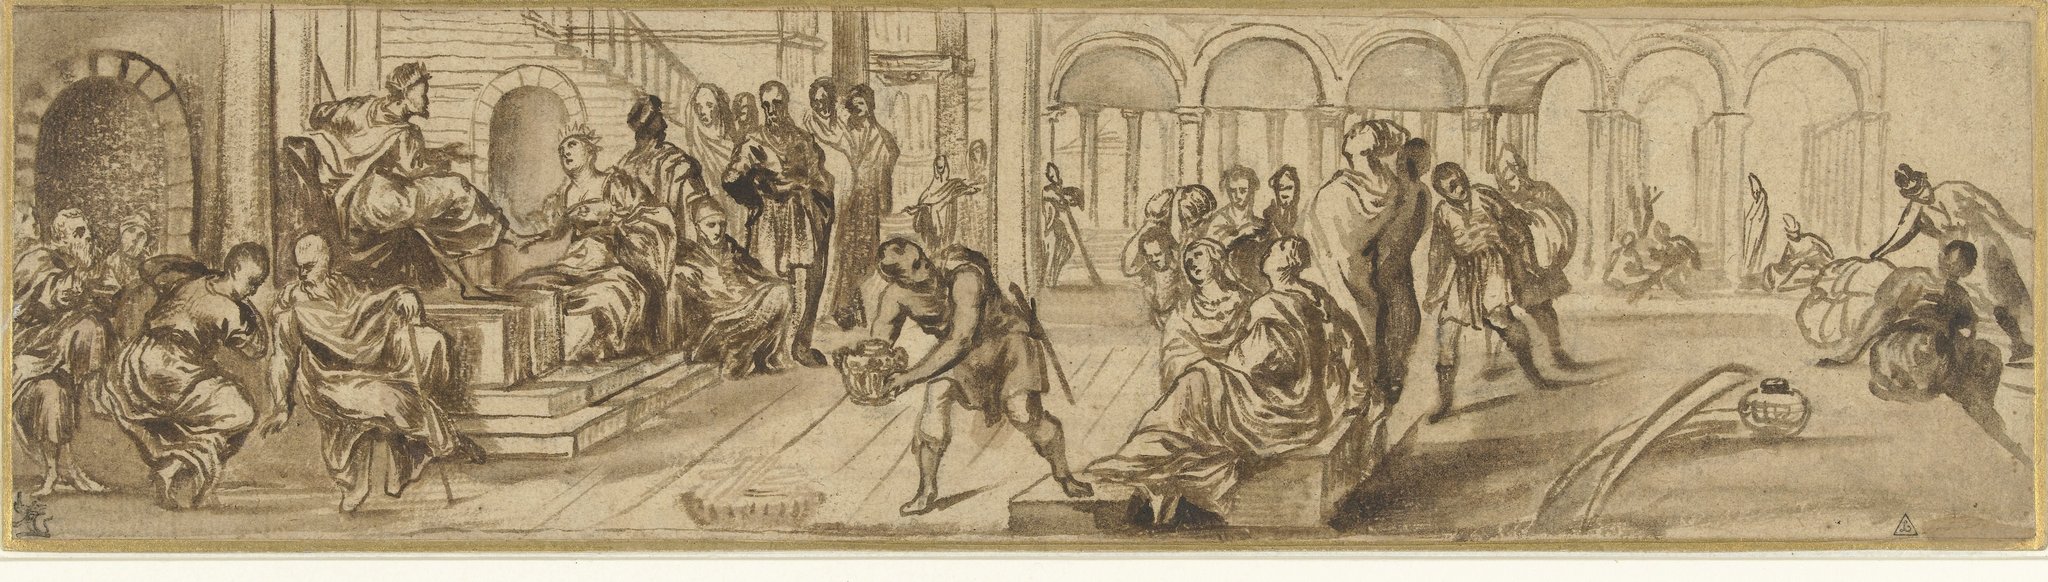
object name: drawing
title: Koningin van Sheba ontvangen door Salomo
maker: Anonymous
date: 1528-1620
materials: chalk, ink, paper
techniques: brush, pen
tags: solomon and the queen of sheba (1 kings 10:1-3; 2 chronicles 9:1-9)